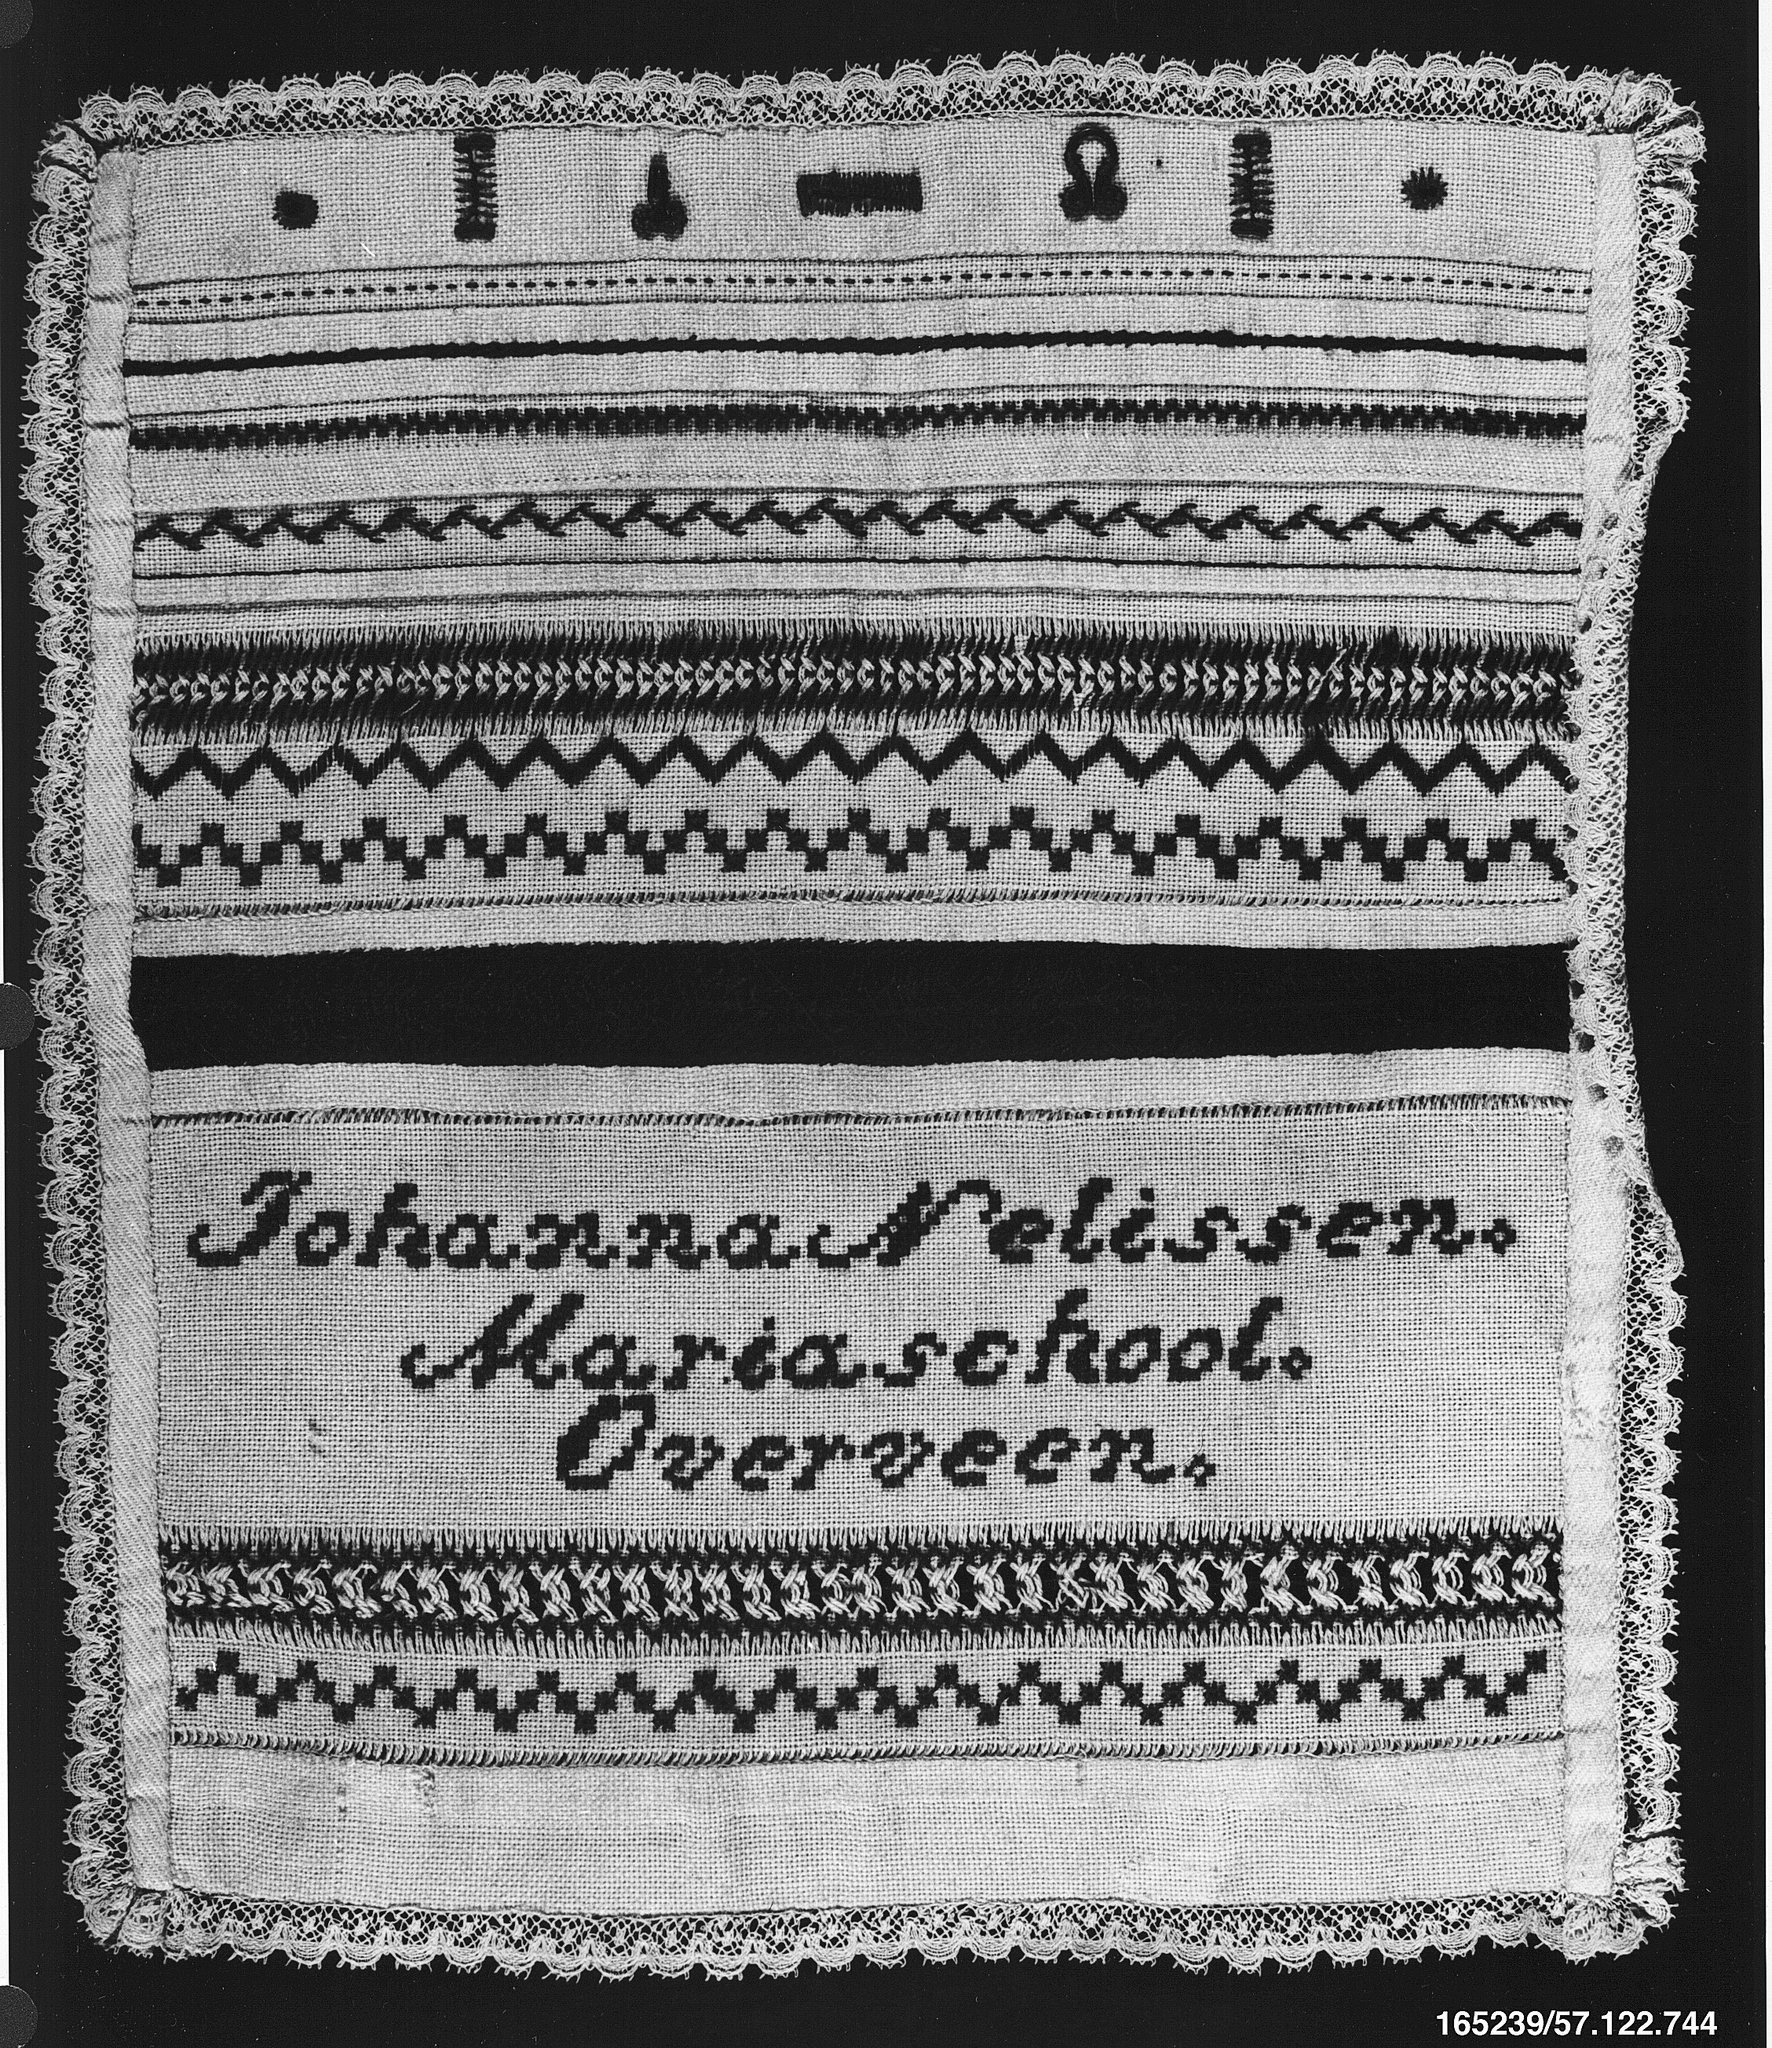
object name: sampler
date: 1801-1900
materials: cotton, silk